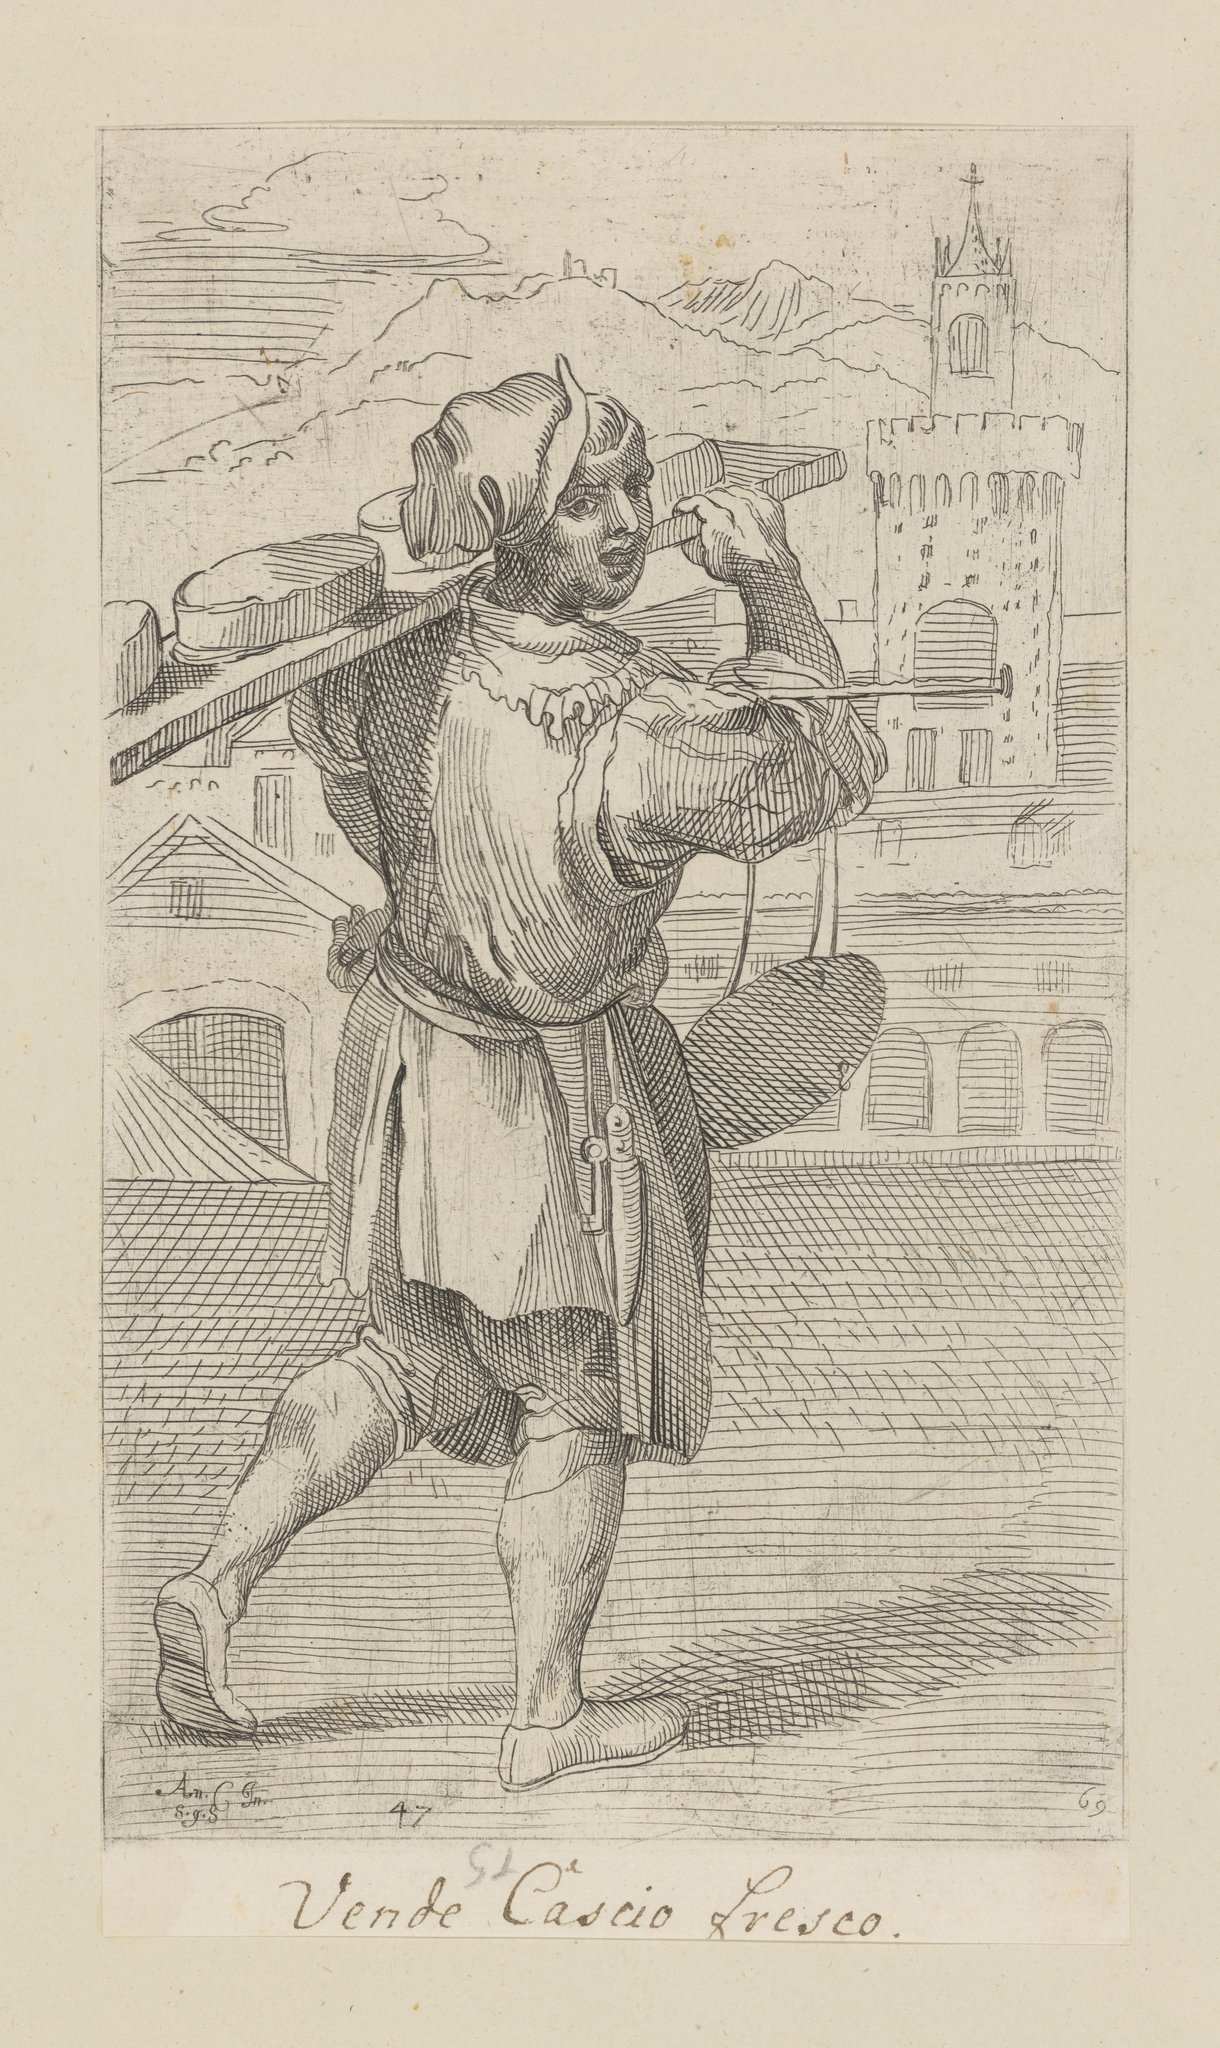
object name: print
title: Plate 47: Fresh cheese vendor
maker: simon guillain ii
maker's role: artist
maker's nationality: french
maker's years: 1618-1718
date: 1646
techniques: etching